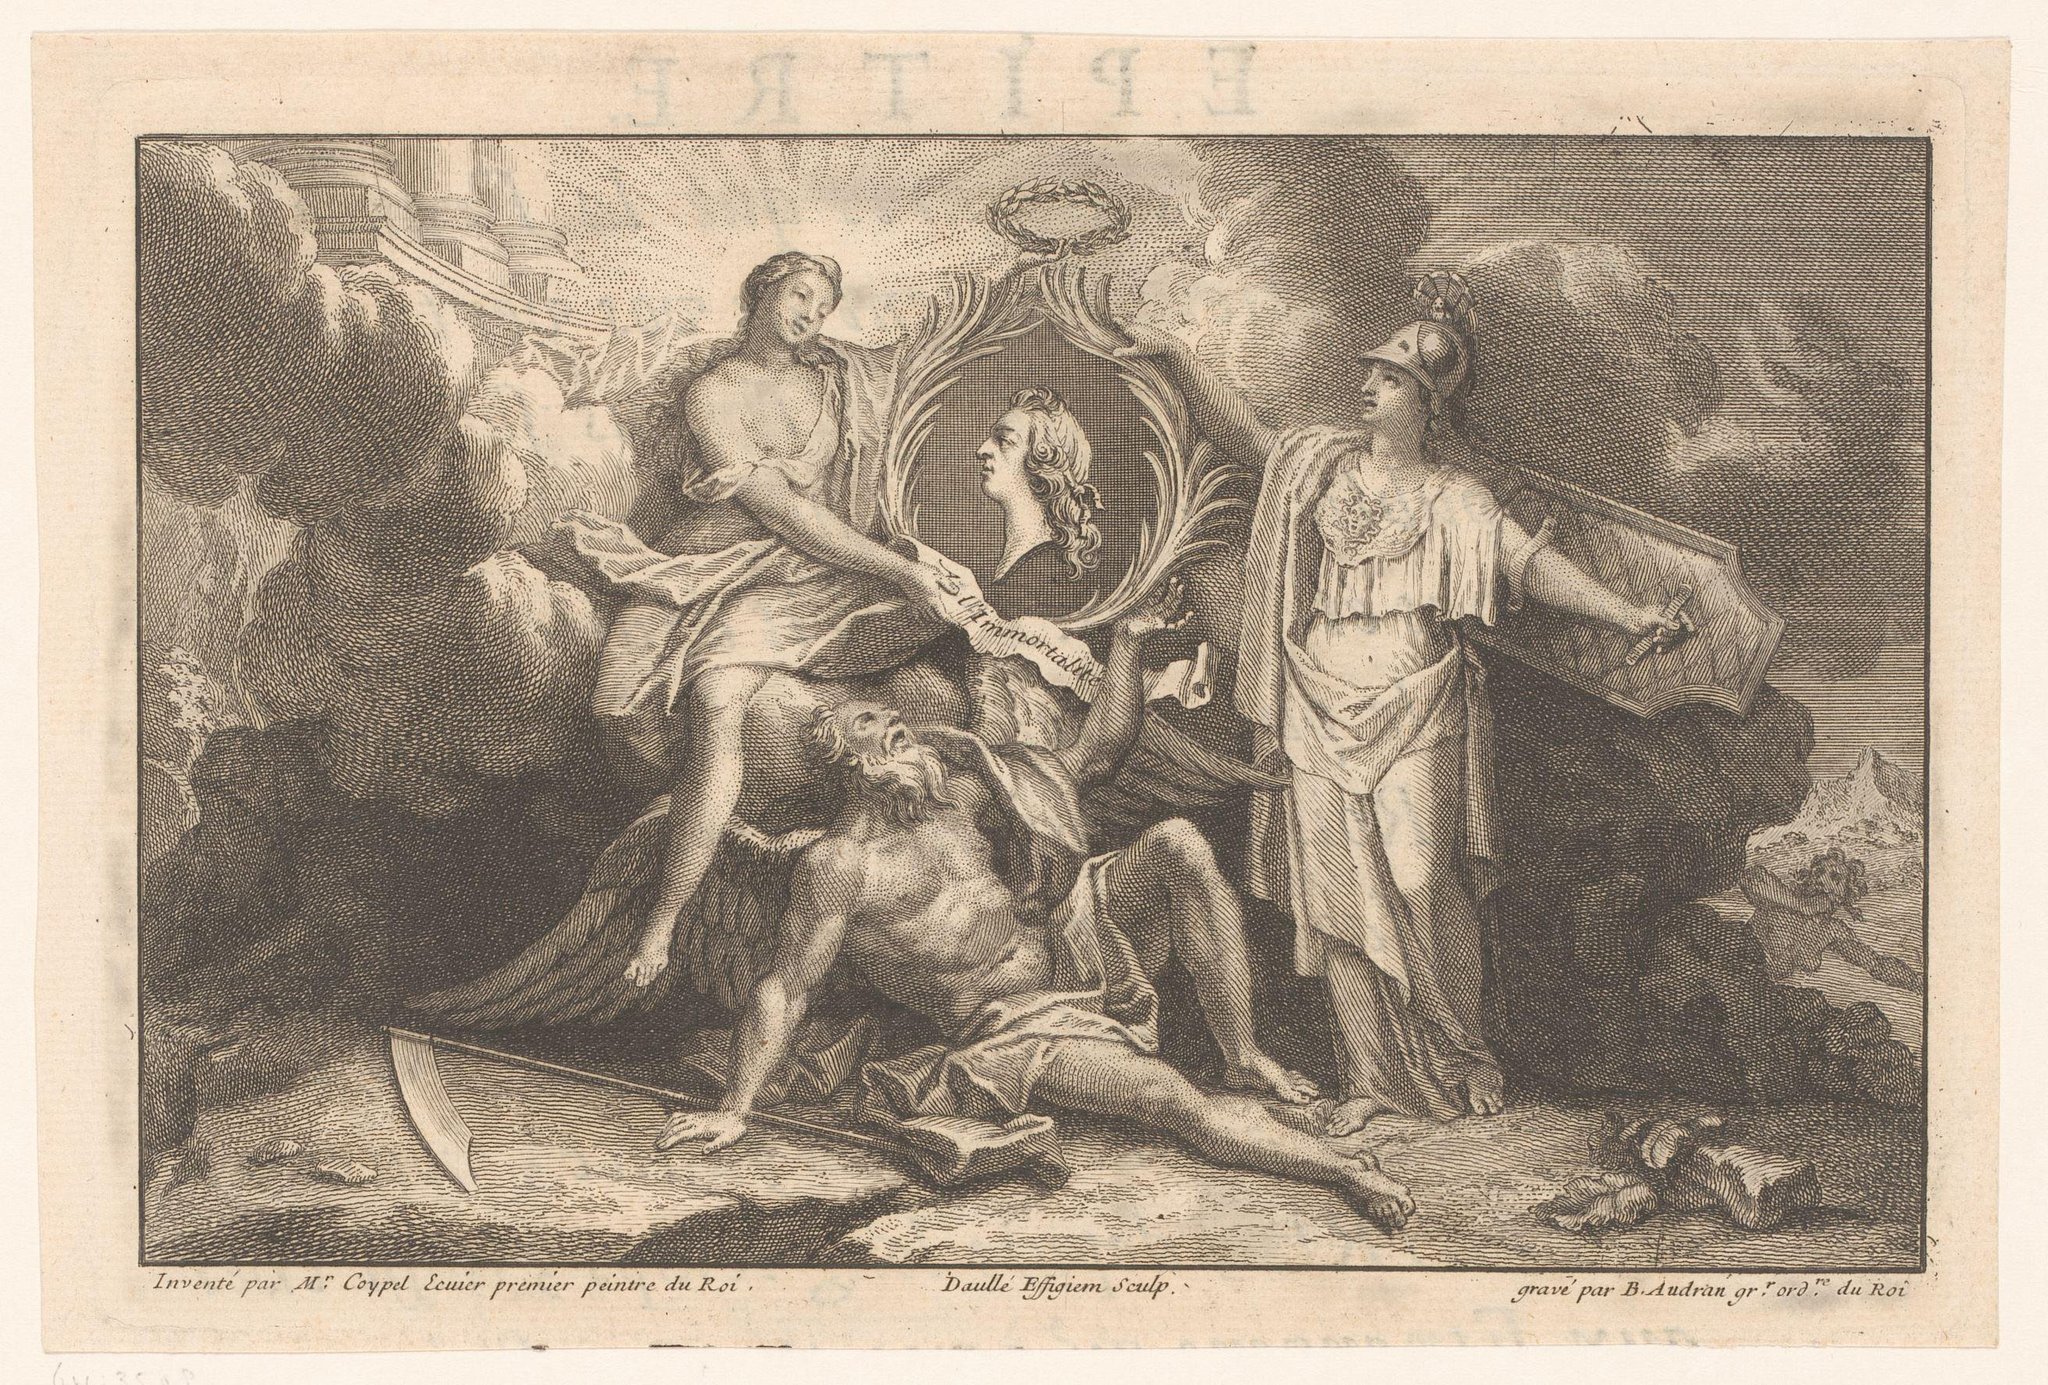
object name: print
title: Allegorie op de onsterfelijkheid van de Franse koning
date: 1713-1722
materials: paper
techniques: engraving, etching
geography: france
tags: minerva as patroness, ruler, sovereign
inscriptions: collector's mark: Lugt 2228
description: Centraal het hoofd van de Franse koning in profiel, met links een allegorische figuur met zonnestralen achteraan, rechts Minerva en onderaan Chronos.